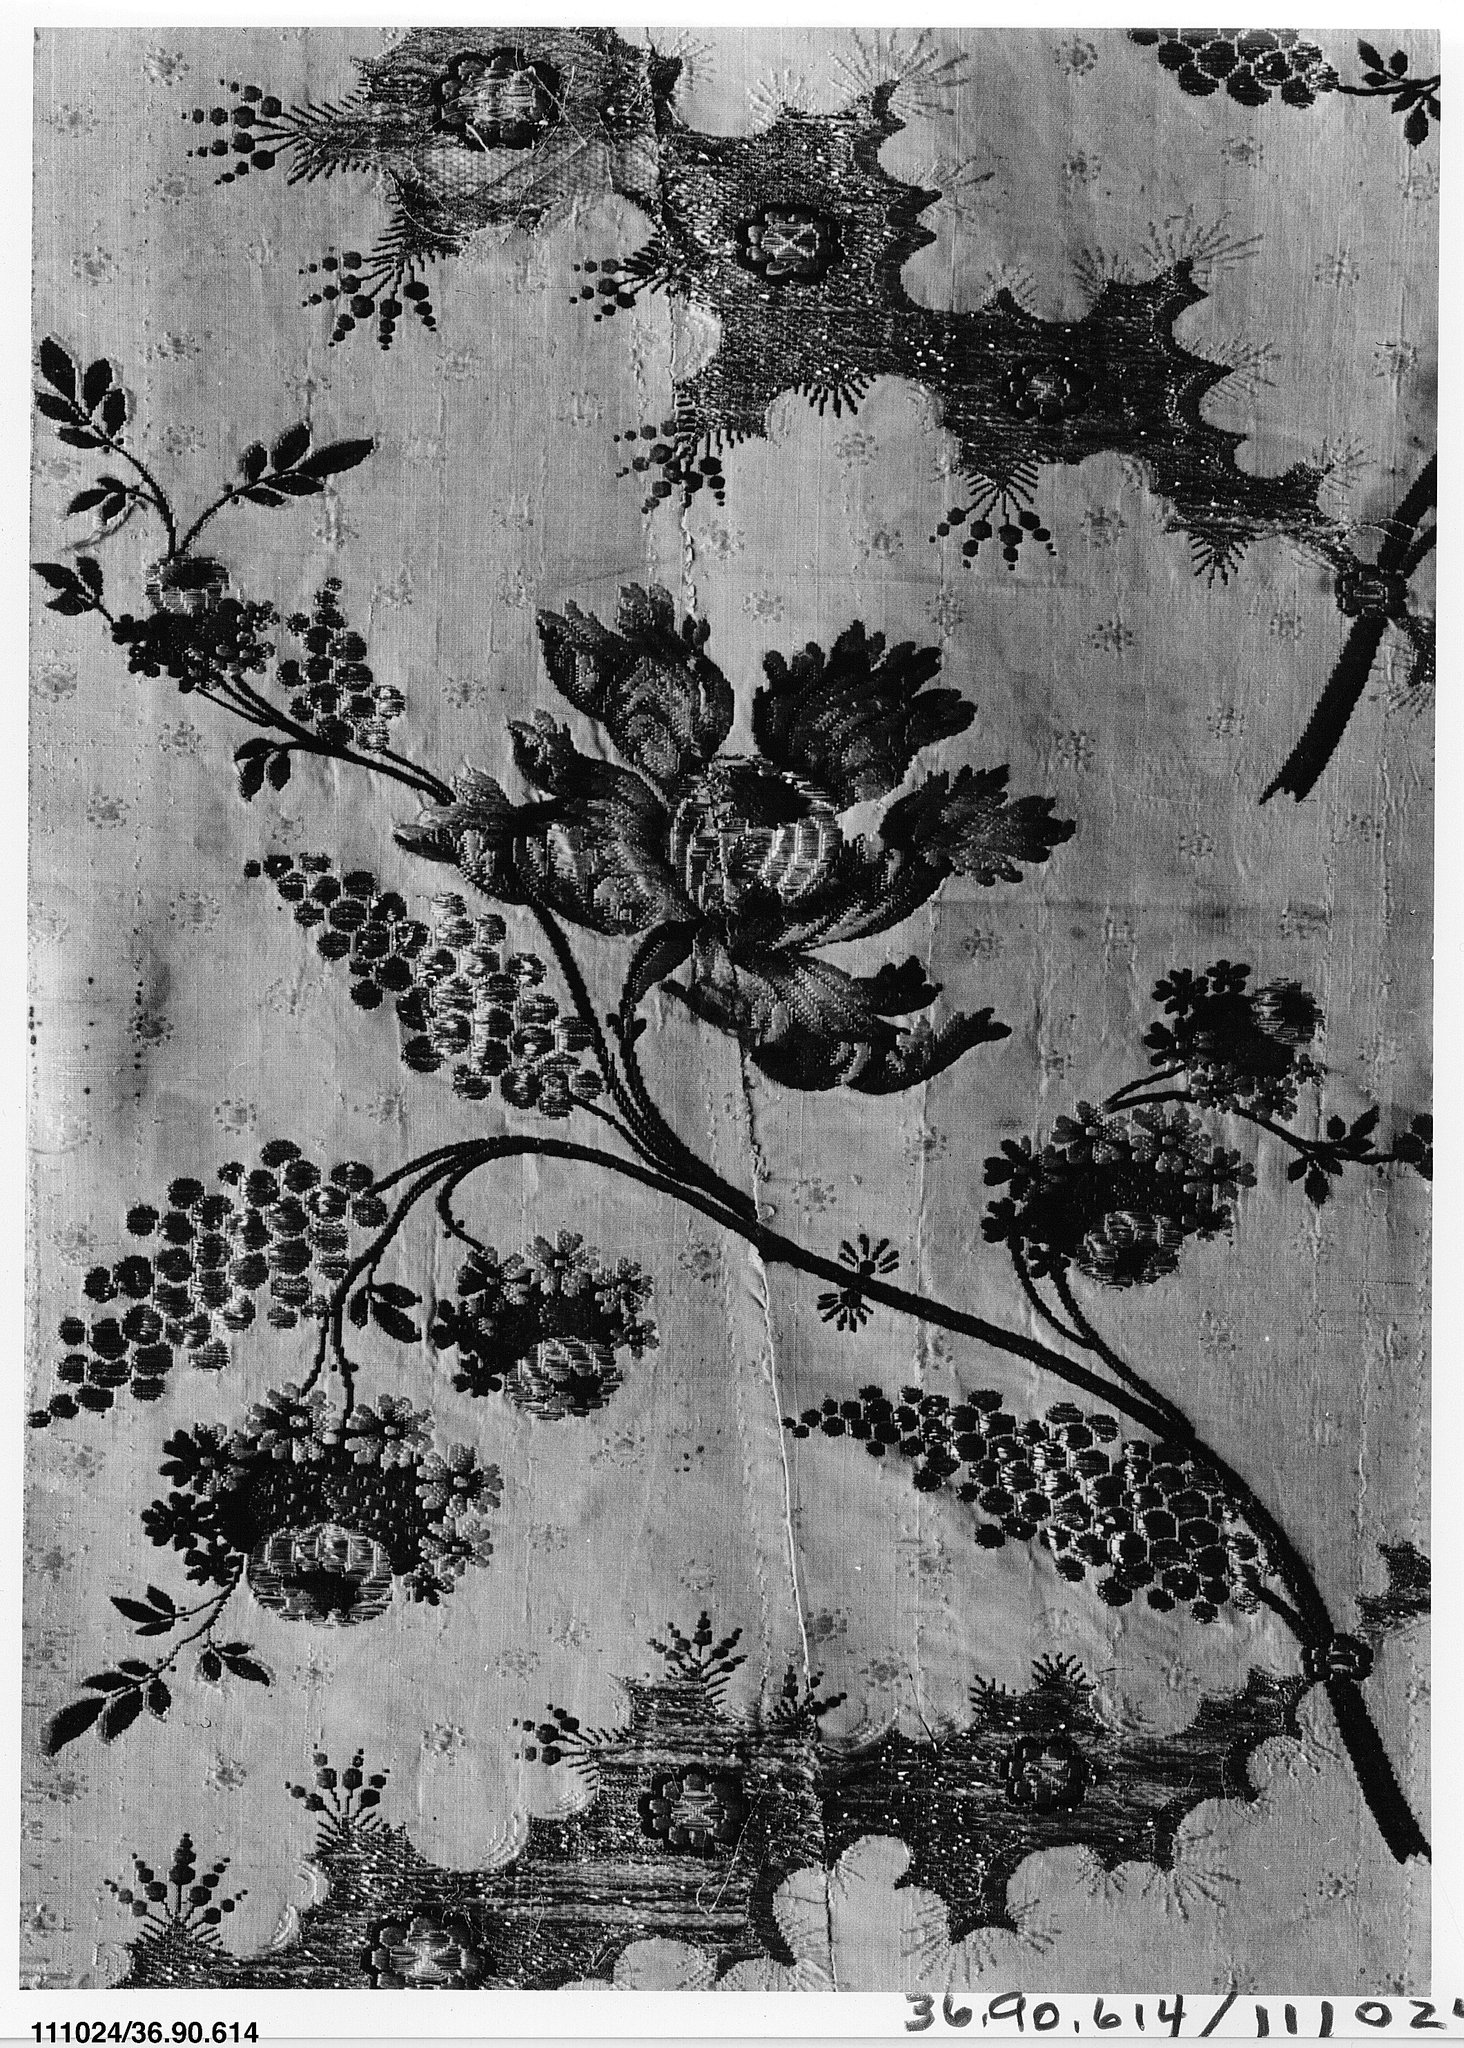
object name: piece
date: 1734-1766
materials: metal thread, silk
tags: flowers